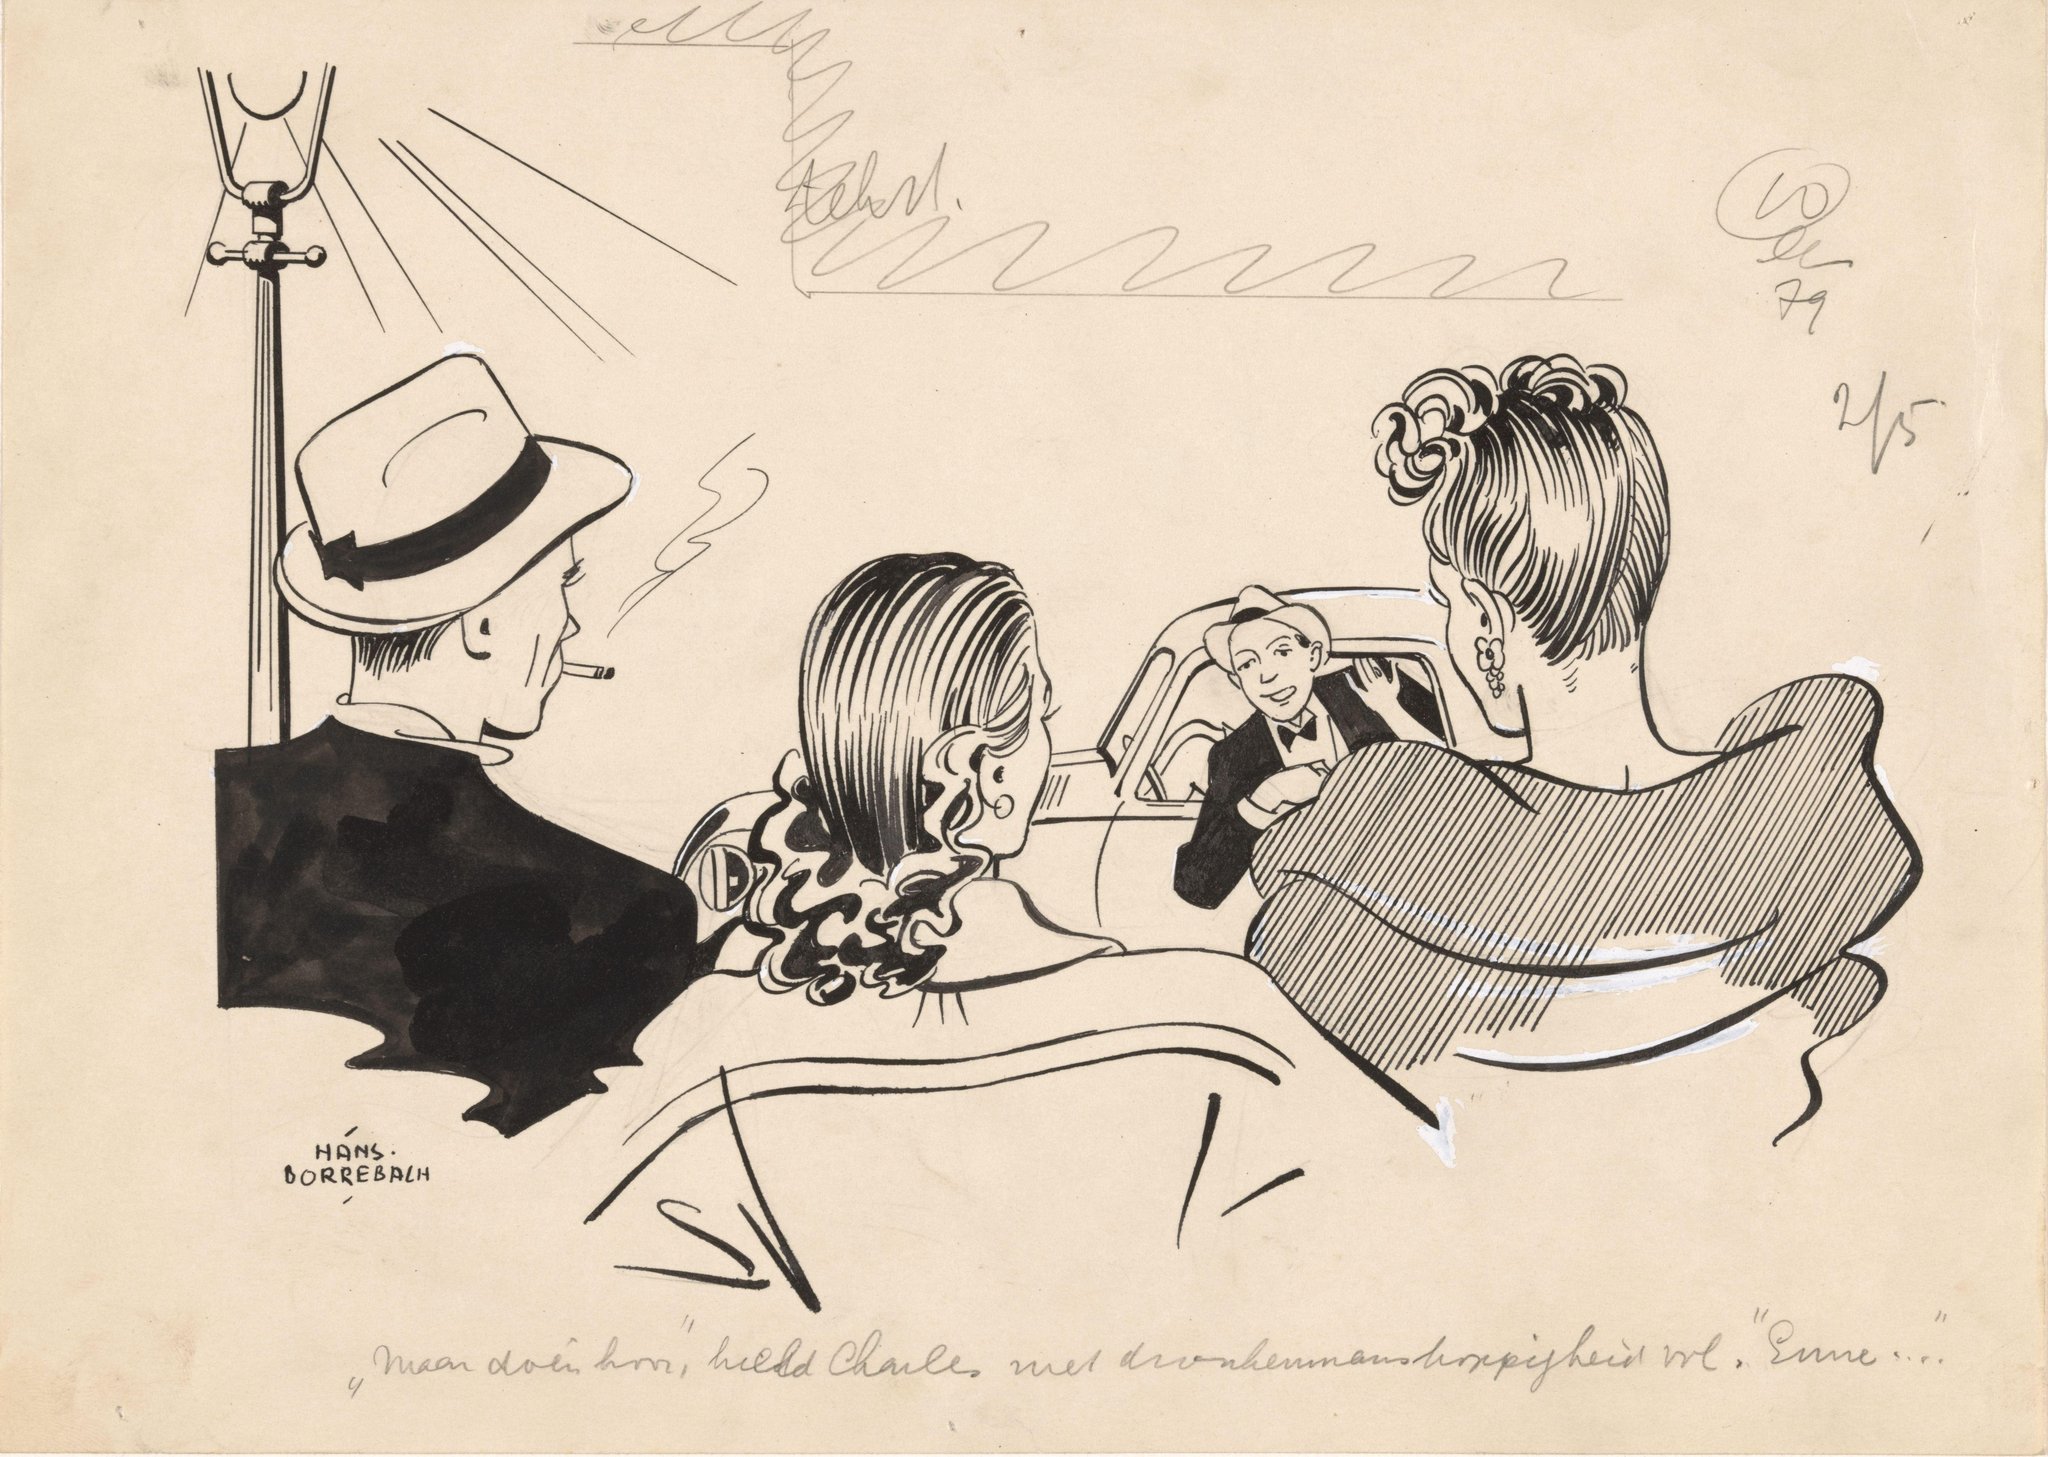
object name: boekillustratie ontwerp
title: Pepita kijkt naar een man in een auto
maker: hans borrebach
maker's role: draughtsman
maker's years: 1903-1991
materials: paint, ink, paper, pencil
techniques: brush, pen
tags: cigarette, street lighting, automobile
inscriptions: collector's mark: Lugt 2228a, signature: ‘HANS./ BORREBACH’, :, annotation: ‘10/ bz/ 79/ "maar doen hoor" hield Charles met dronkenmanskoppigheid vol. "Enne...."’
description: Pepita staat tussen een jonge man en vrouw in bij een straatlamp en kijkt naar een man met hoed die met zijn hoofd uit het raam van een auto hangt.